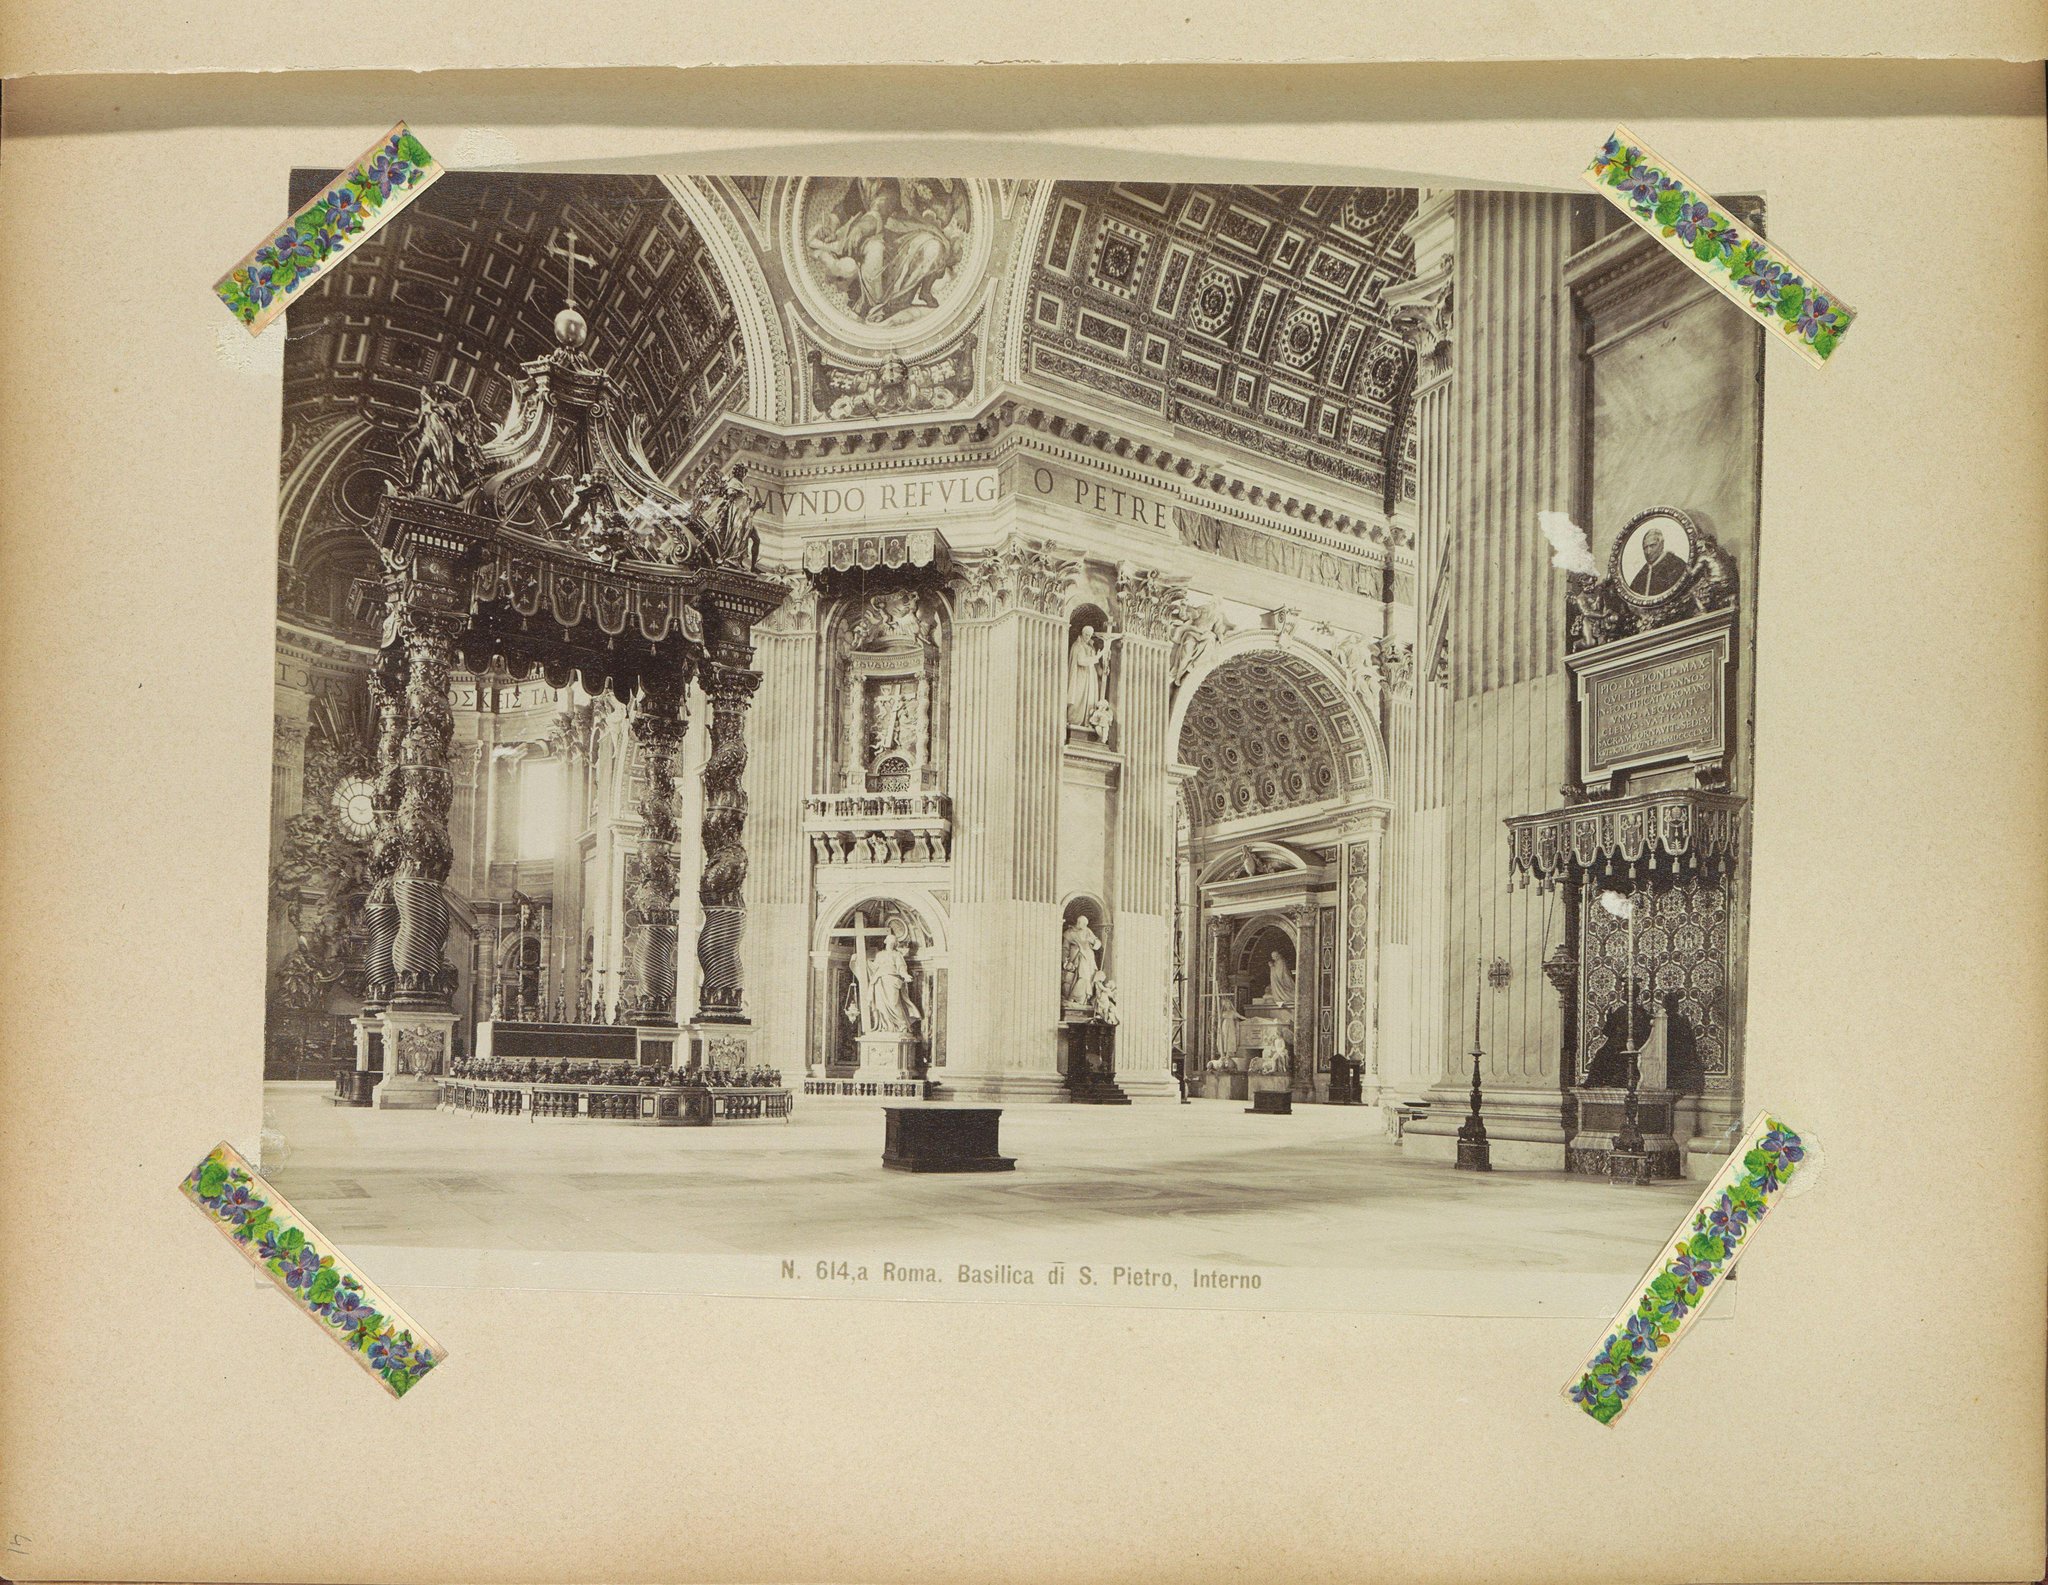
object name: photograph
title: Interieur van de Sint-Pietersbasiliek in Vaticaanstad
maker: Anonymous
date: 1860-1900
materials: photographic support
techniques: albumen print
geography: sint-pietersbasiliek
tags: parts of church interior: choir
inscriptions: number: ‘614,a’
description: Onderdeel van Fotoalbum met opnames van bezienswaardigheden in Italiaanse steden en van kunstwerken.